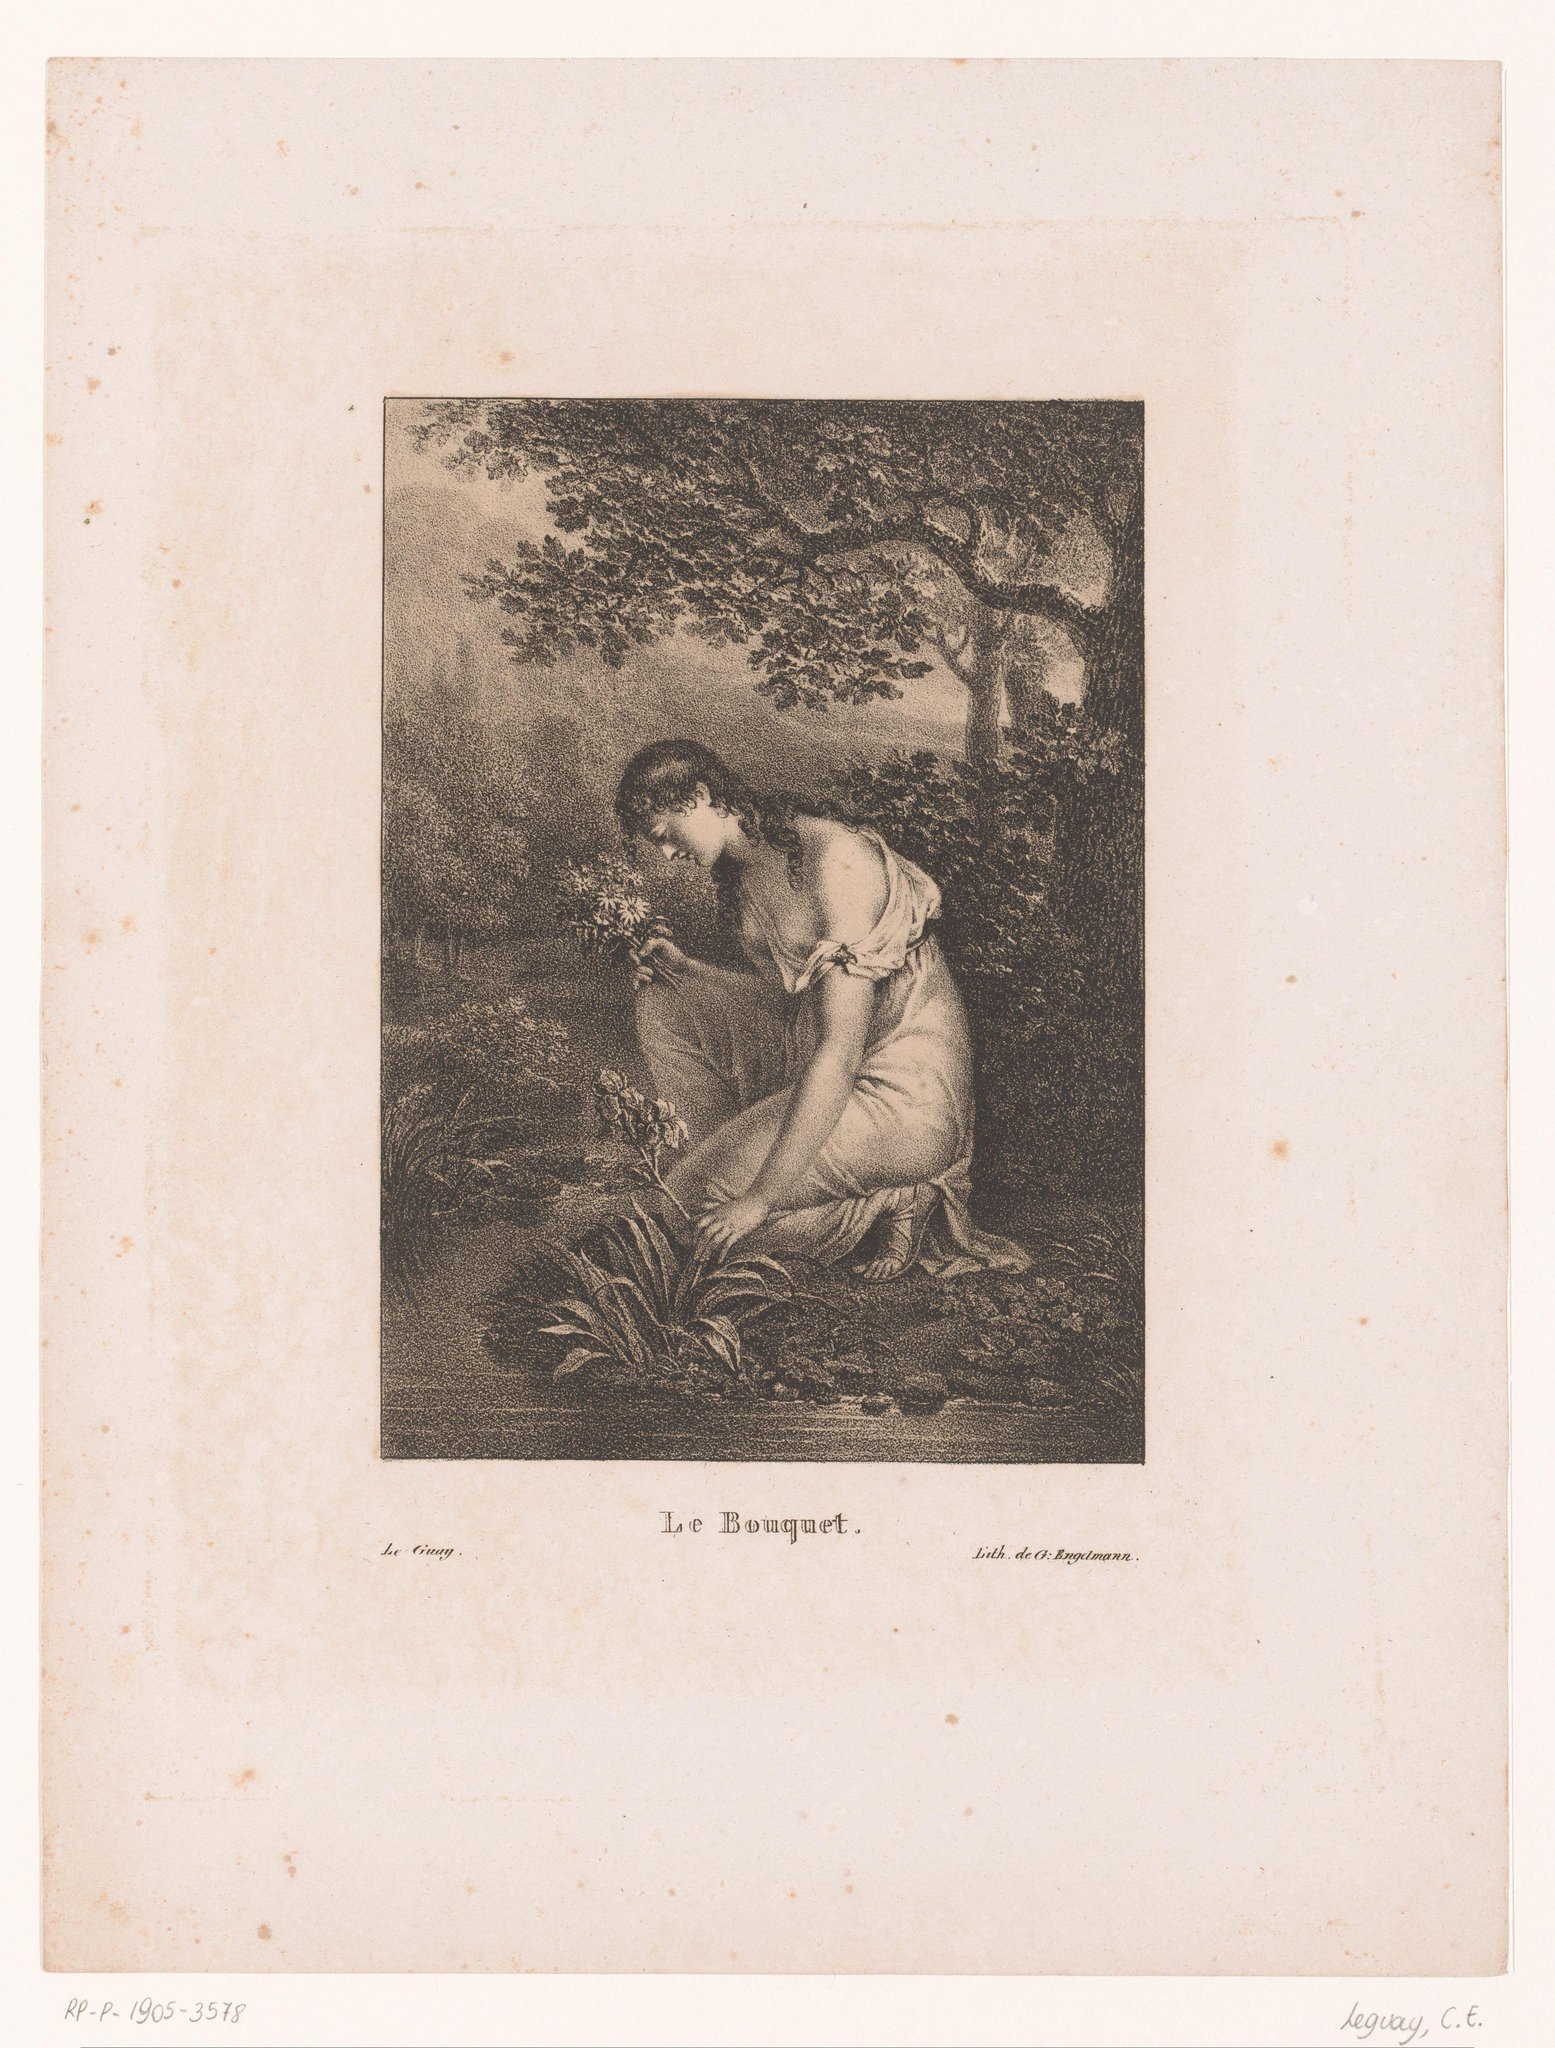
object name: print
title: Le Bouquet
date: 1820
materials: paper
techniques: tone lithography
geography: paris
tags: picking flowers, adolescent, young woman, maiden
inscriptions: collector's mark: Lugt 2228a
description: Prent gebruikt voor: L'Album lithographique dessiné par les peintres de Sèvres, 1820.